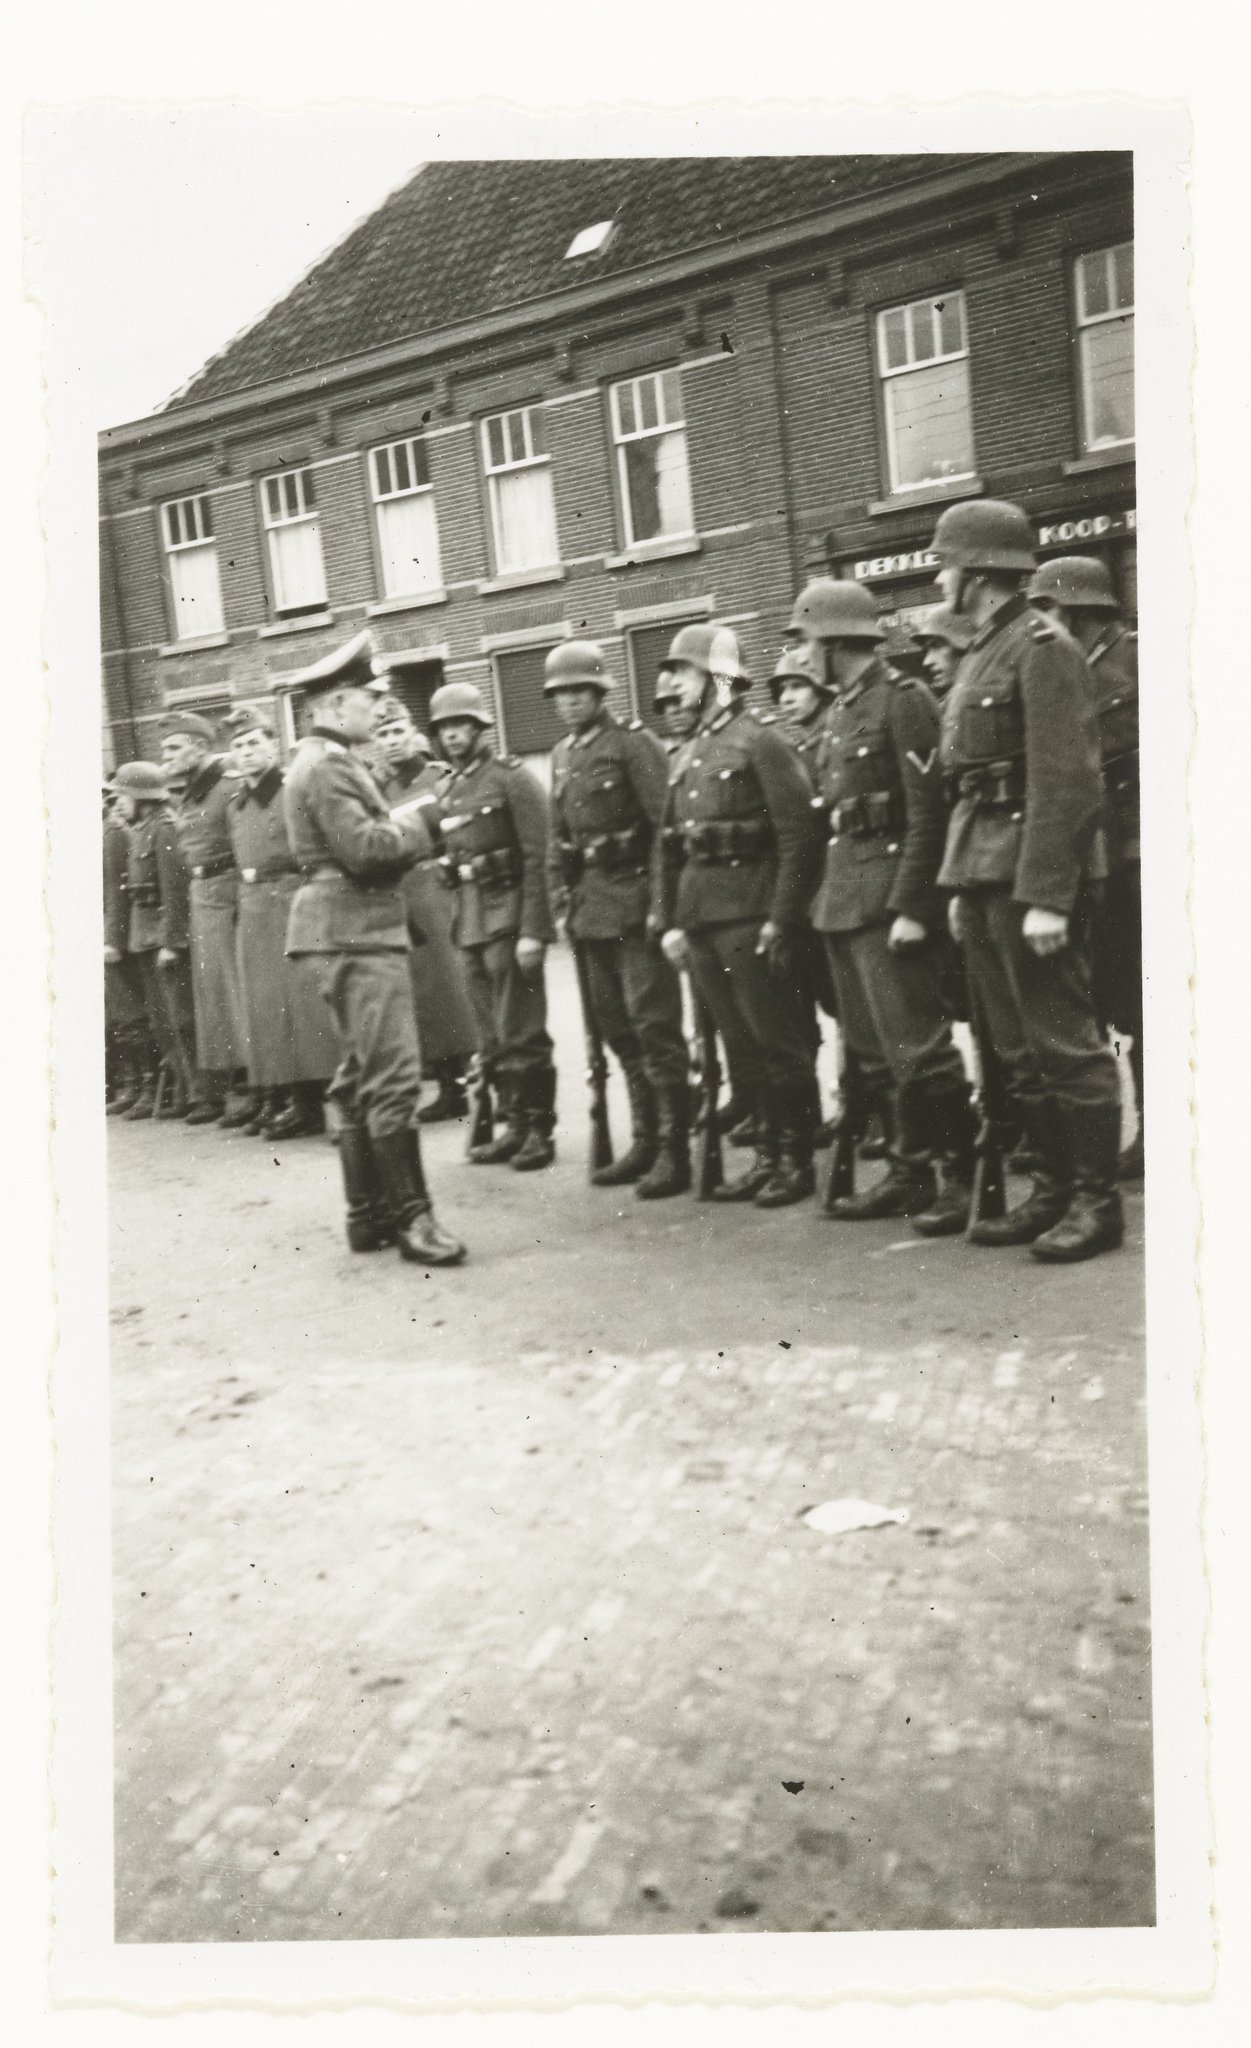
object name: photograph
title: Wehrmacht kompagnie op appel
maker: Anonymous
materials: photographic support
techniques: gelatin silver print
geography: raamsdonksveer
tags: review, inspection (of company, unit, troop), occupation ~ war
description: Een kompagnie van de Wehrmacht staat in een straat op appel. Tegenover de manschappen staat hun commandant. Achterop staat: In Holland. Morgens beim antreten.